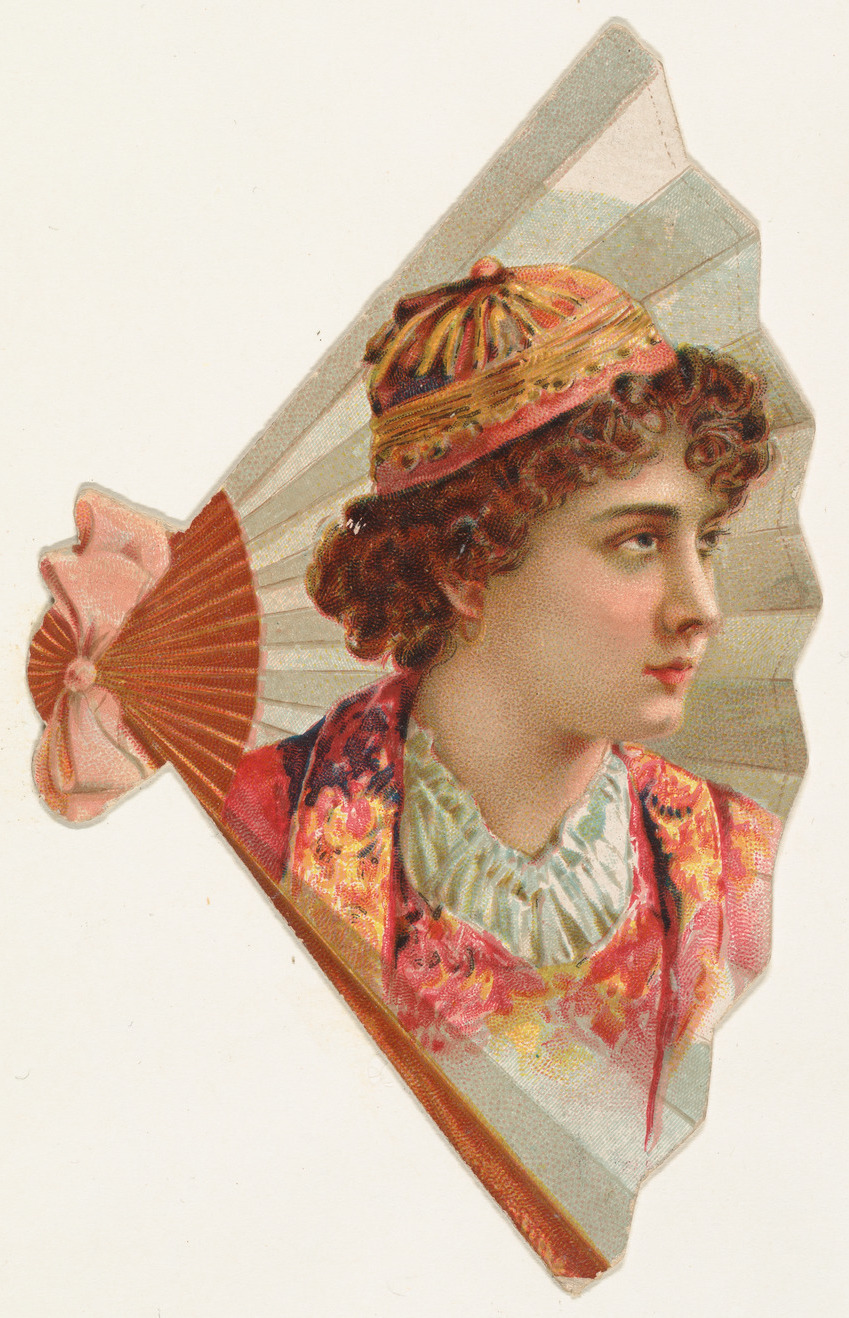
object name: print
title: Open fan, from the Novelties series (N122) issued by Gail & Ax Tobacco to promote Navy Long Cut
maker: gail & ax tobacco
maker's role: publisher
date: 1889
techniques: color lithograph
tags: fans,women